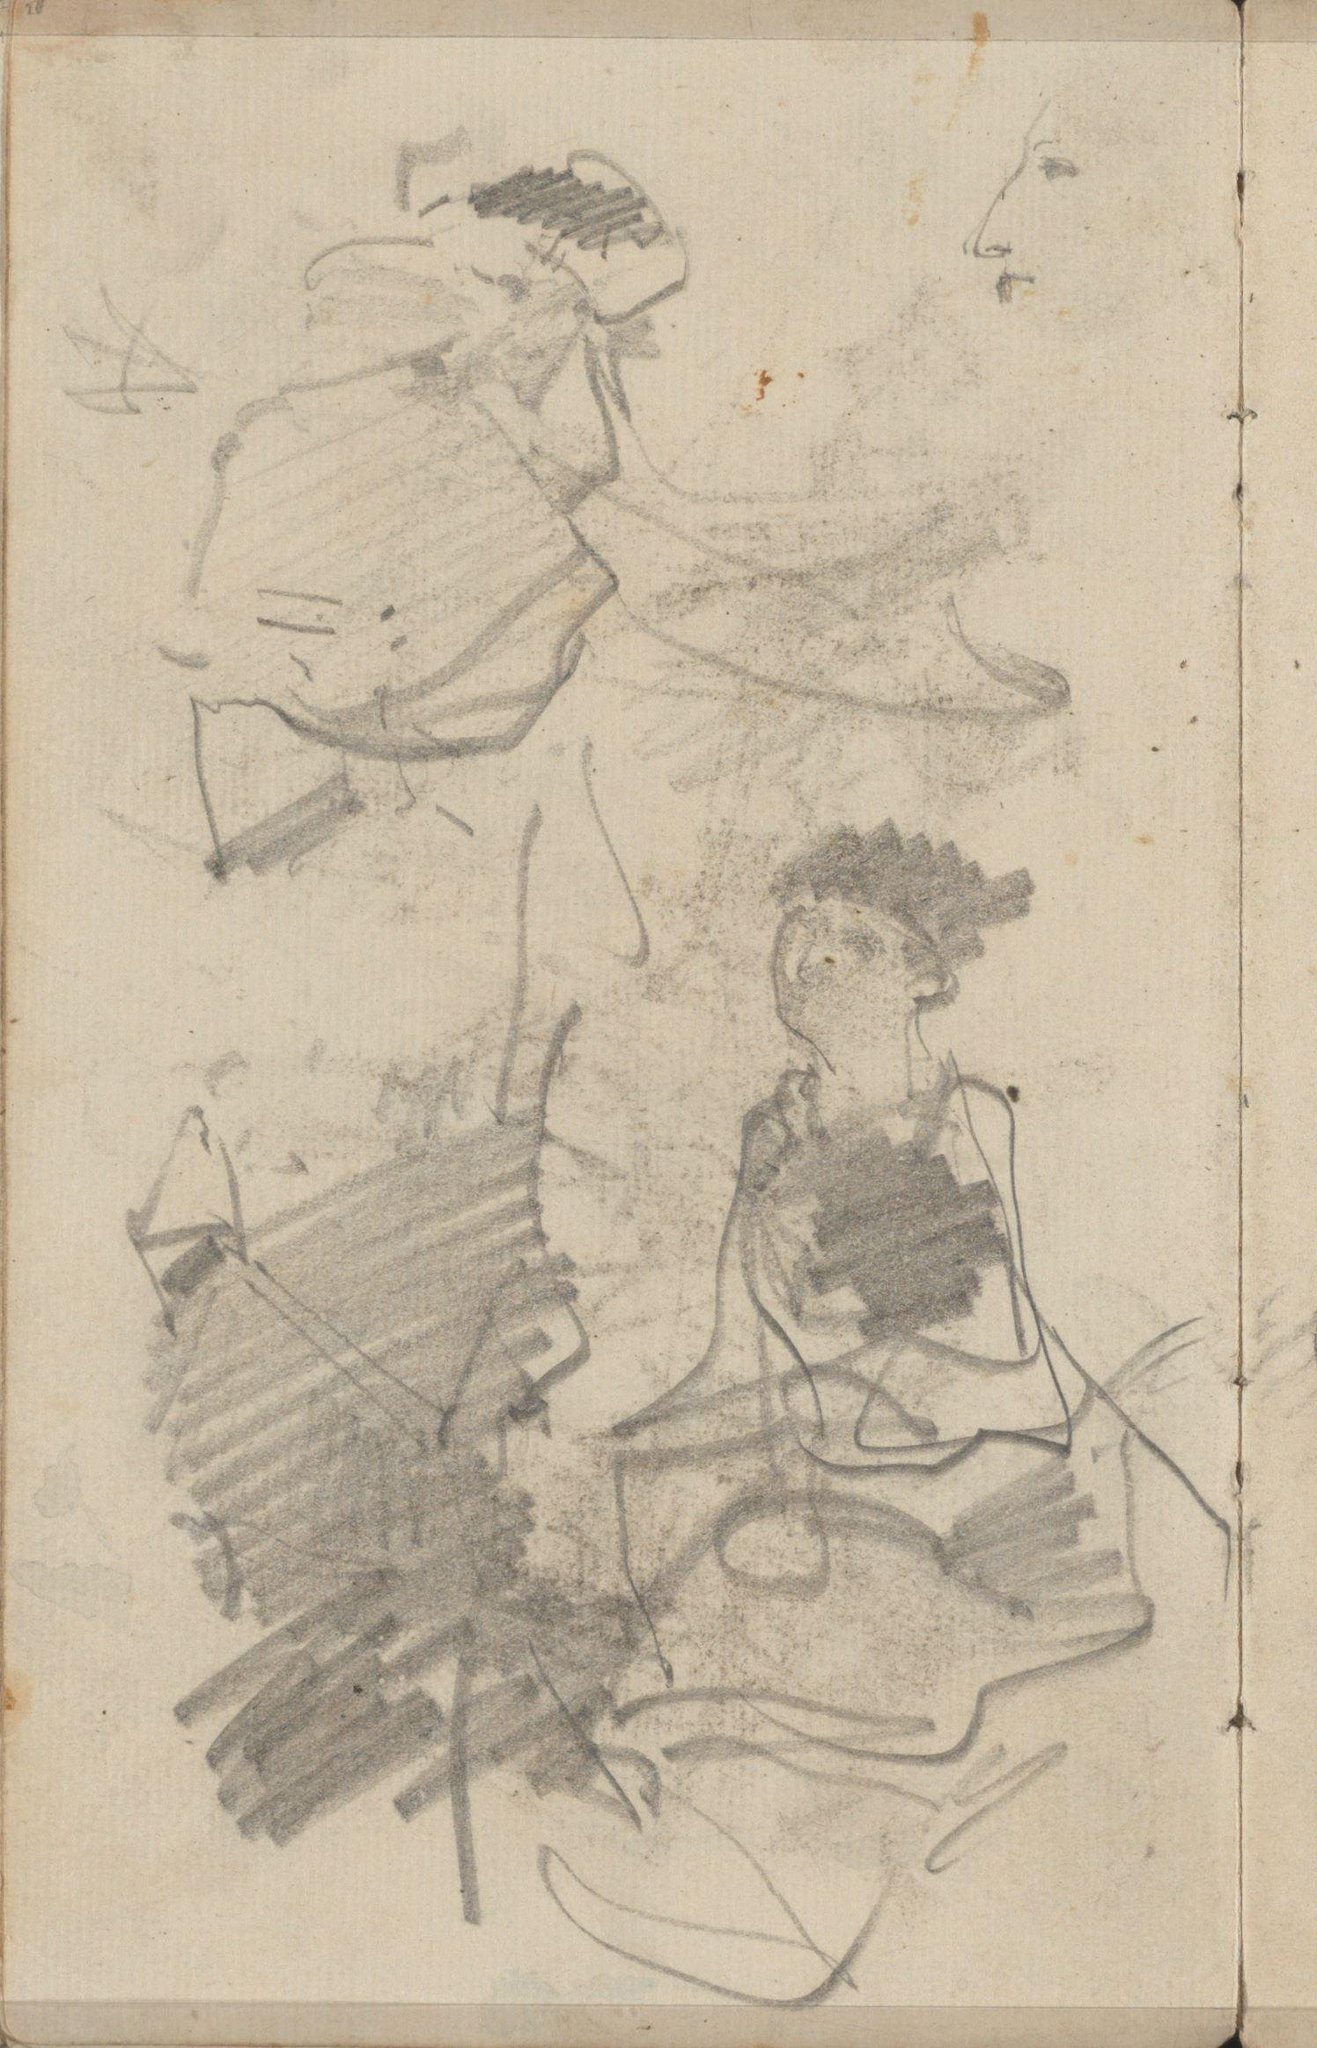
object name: sketchbook leaf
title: Figuurstudies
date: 1881-1883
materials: paper, pencil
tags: head (human), sitting figure - aa - female human figure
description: Pagina 28 uit een schetsboek met 29 bladen.